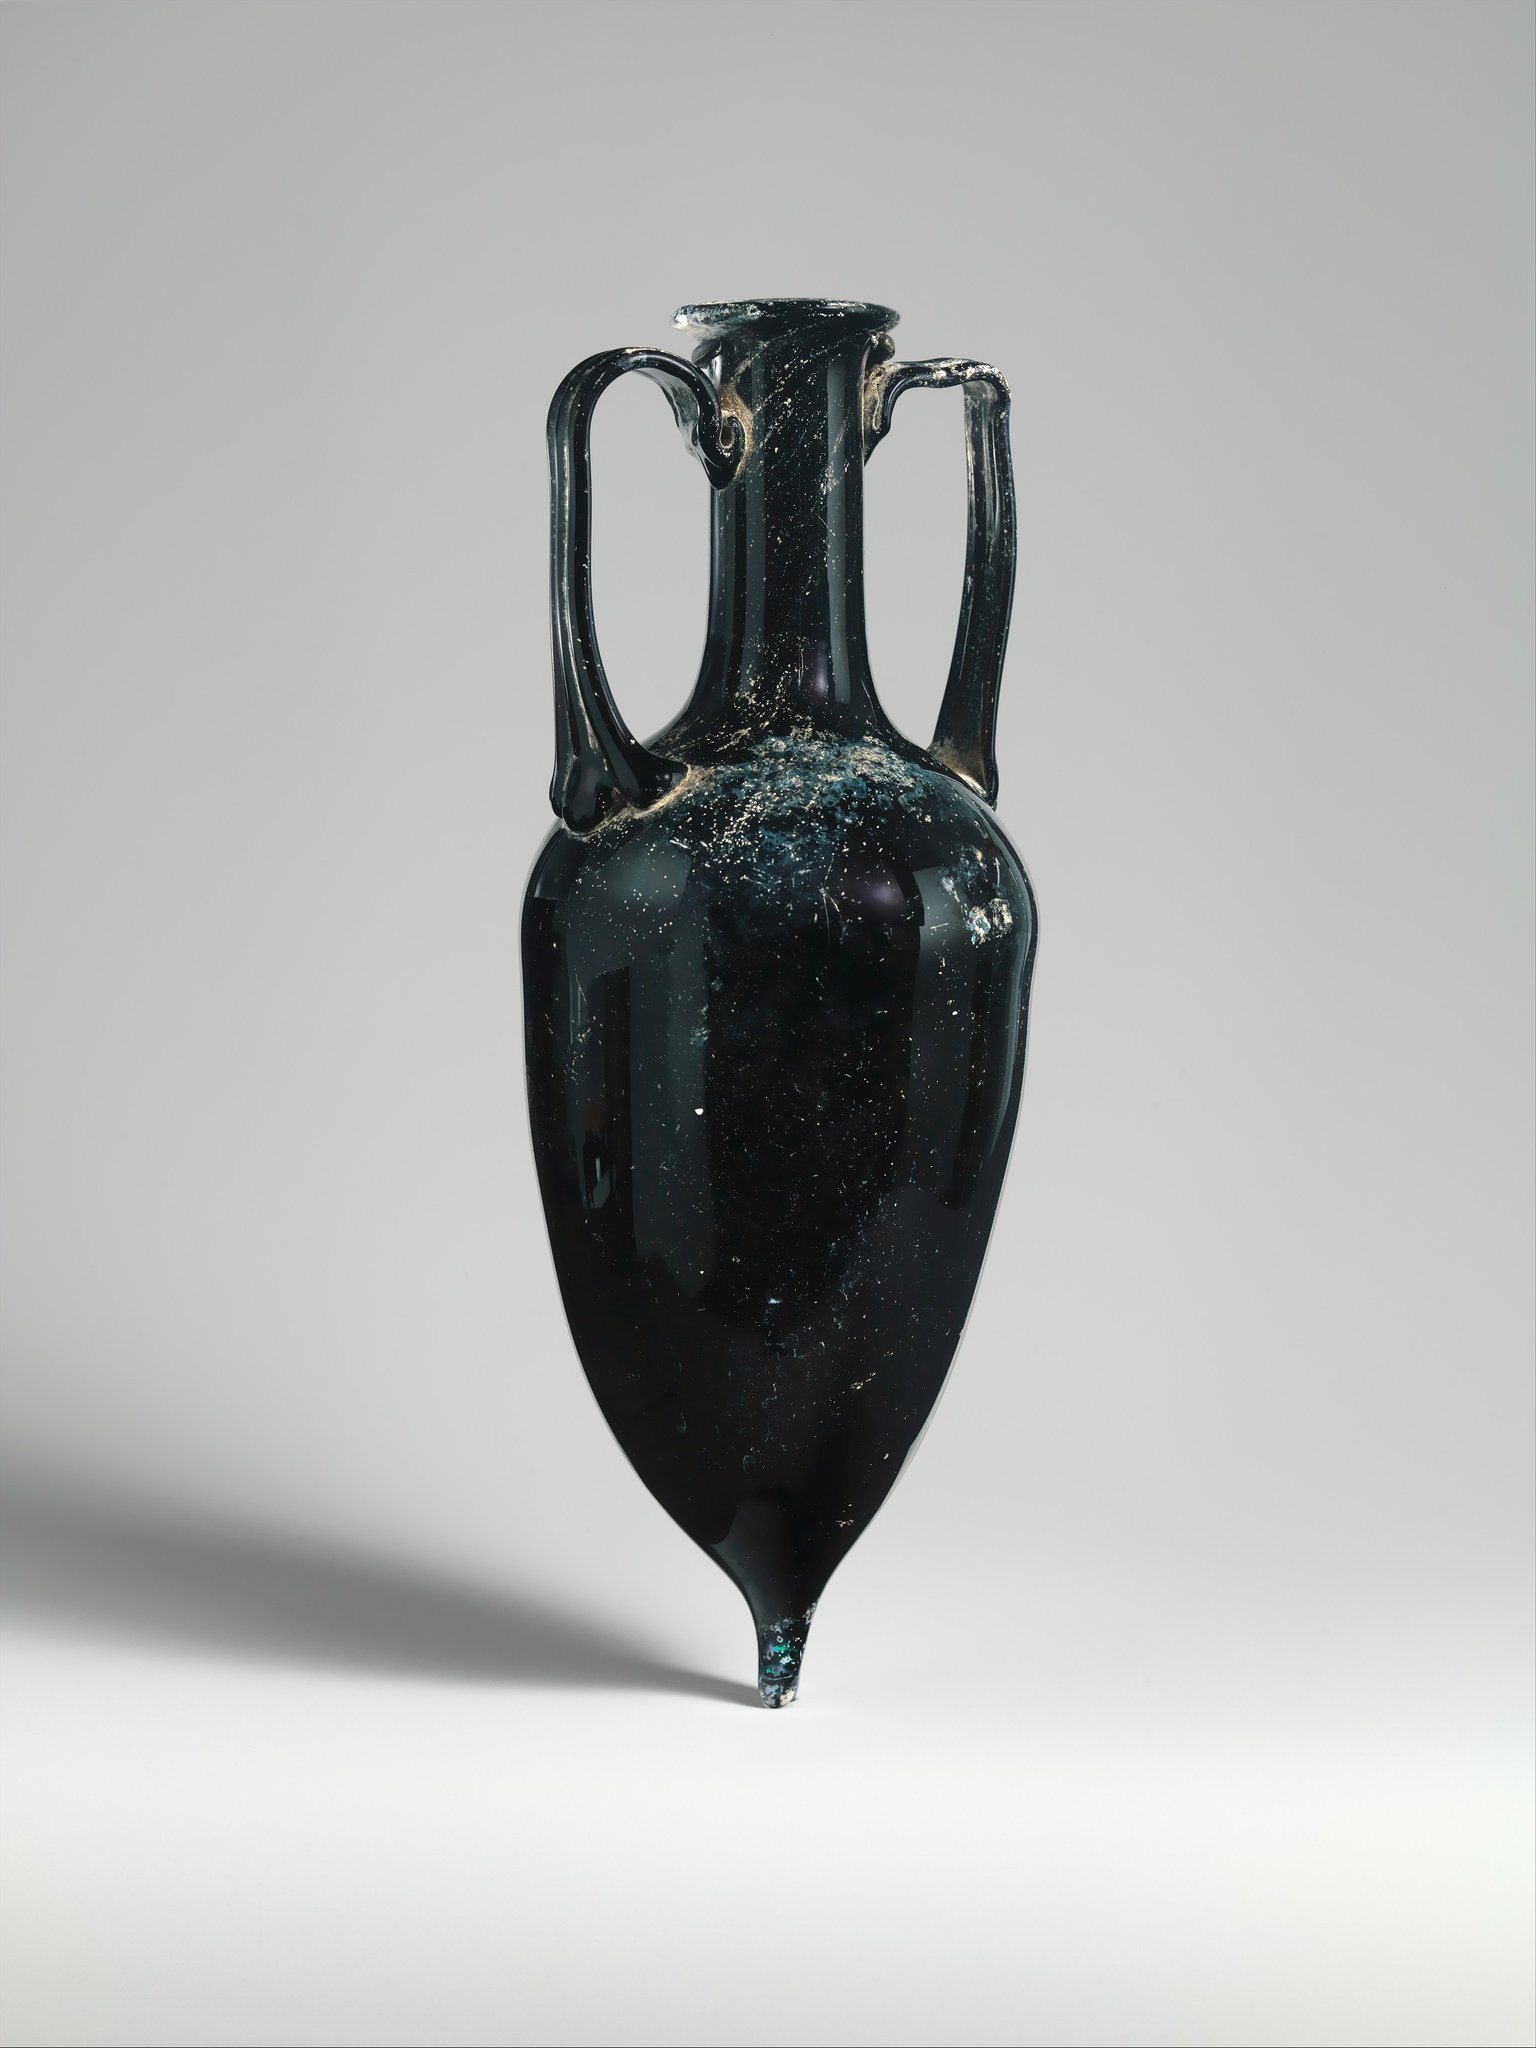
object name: amphora, pointed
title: Glass two-handled bottle (amphora)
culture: roman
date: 1-50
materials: glass